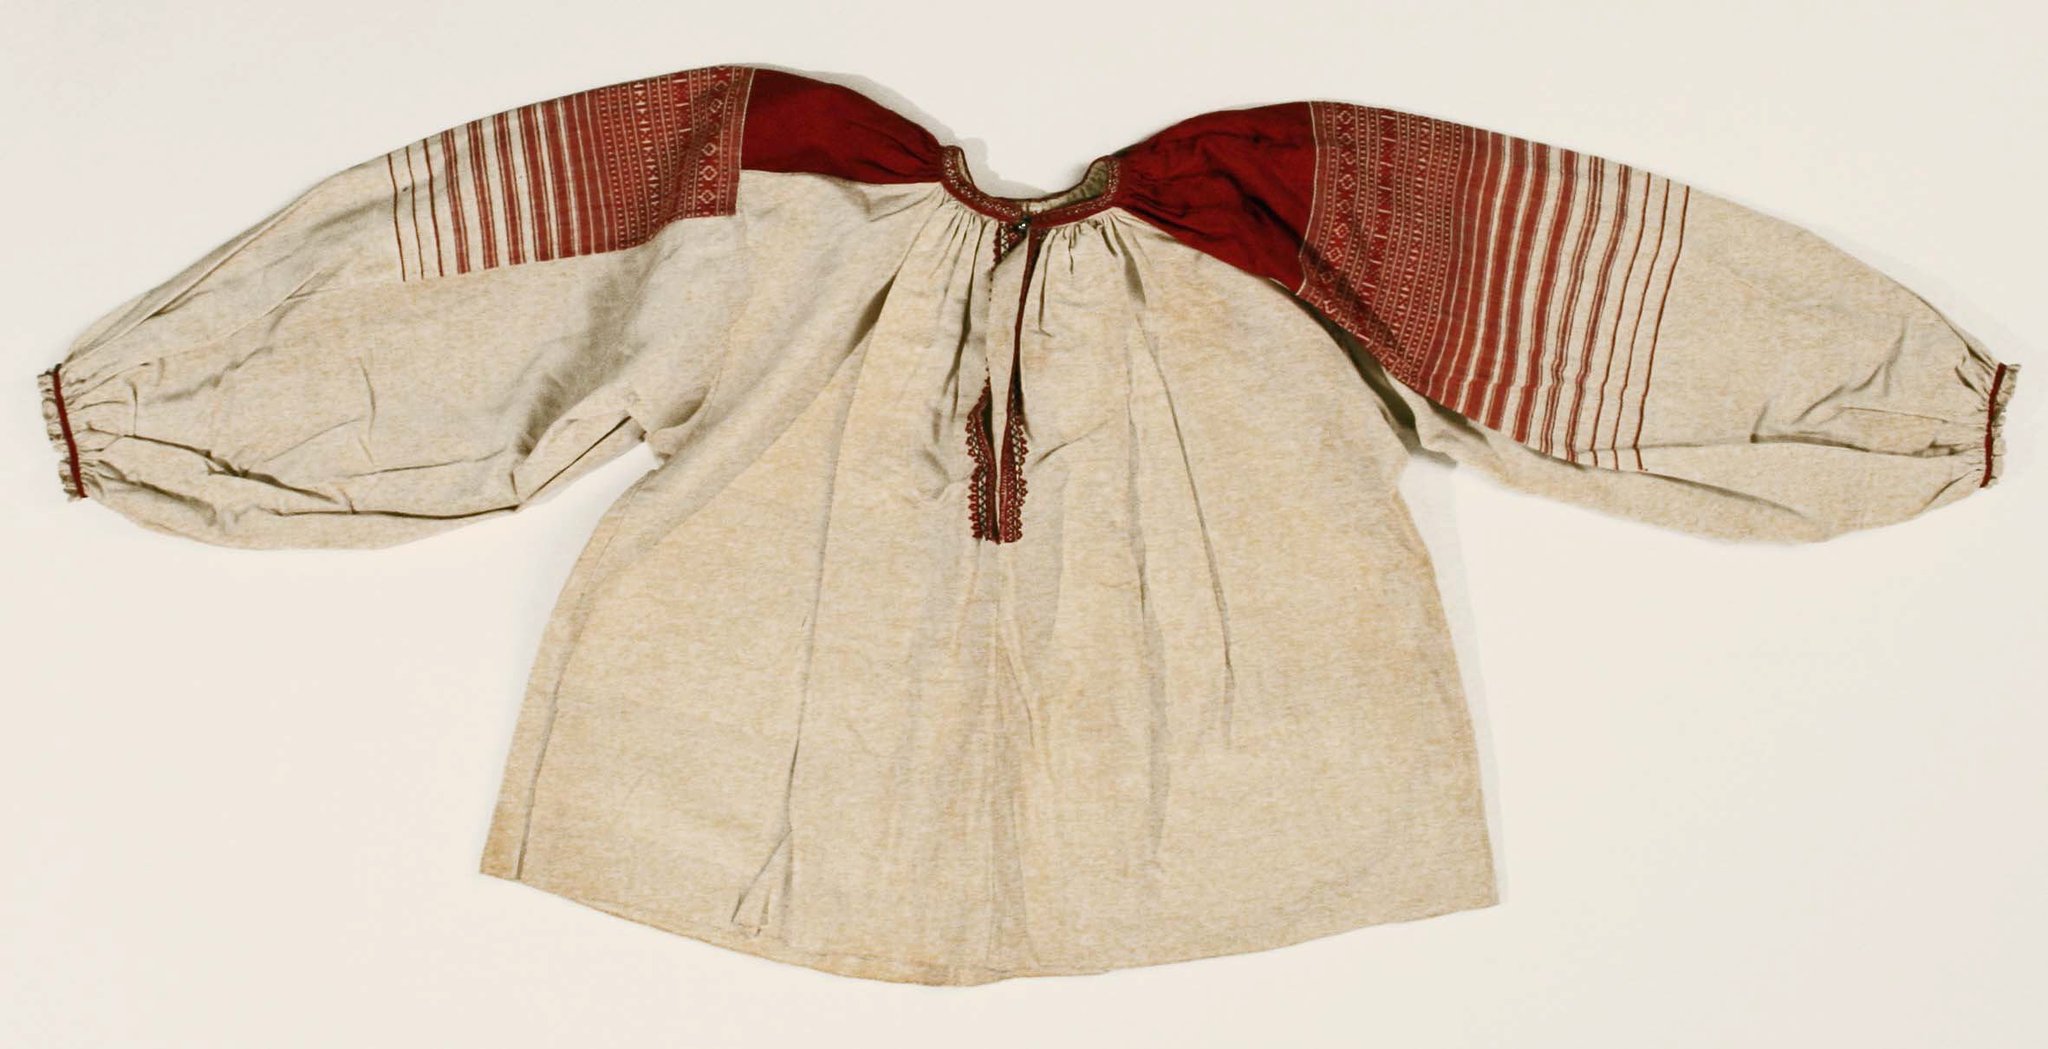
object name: blouse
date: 1801-1900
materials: cotton, linen